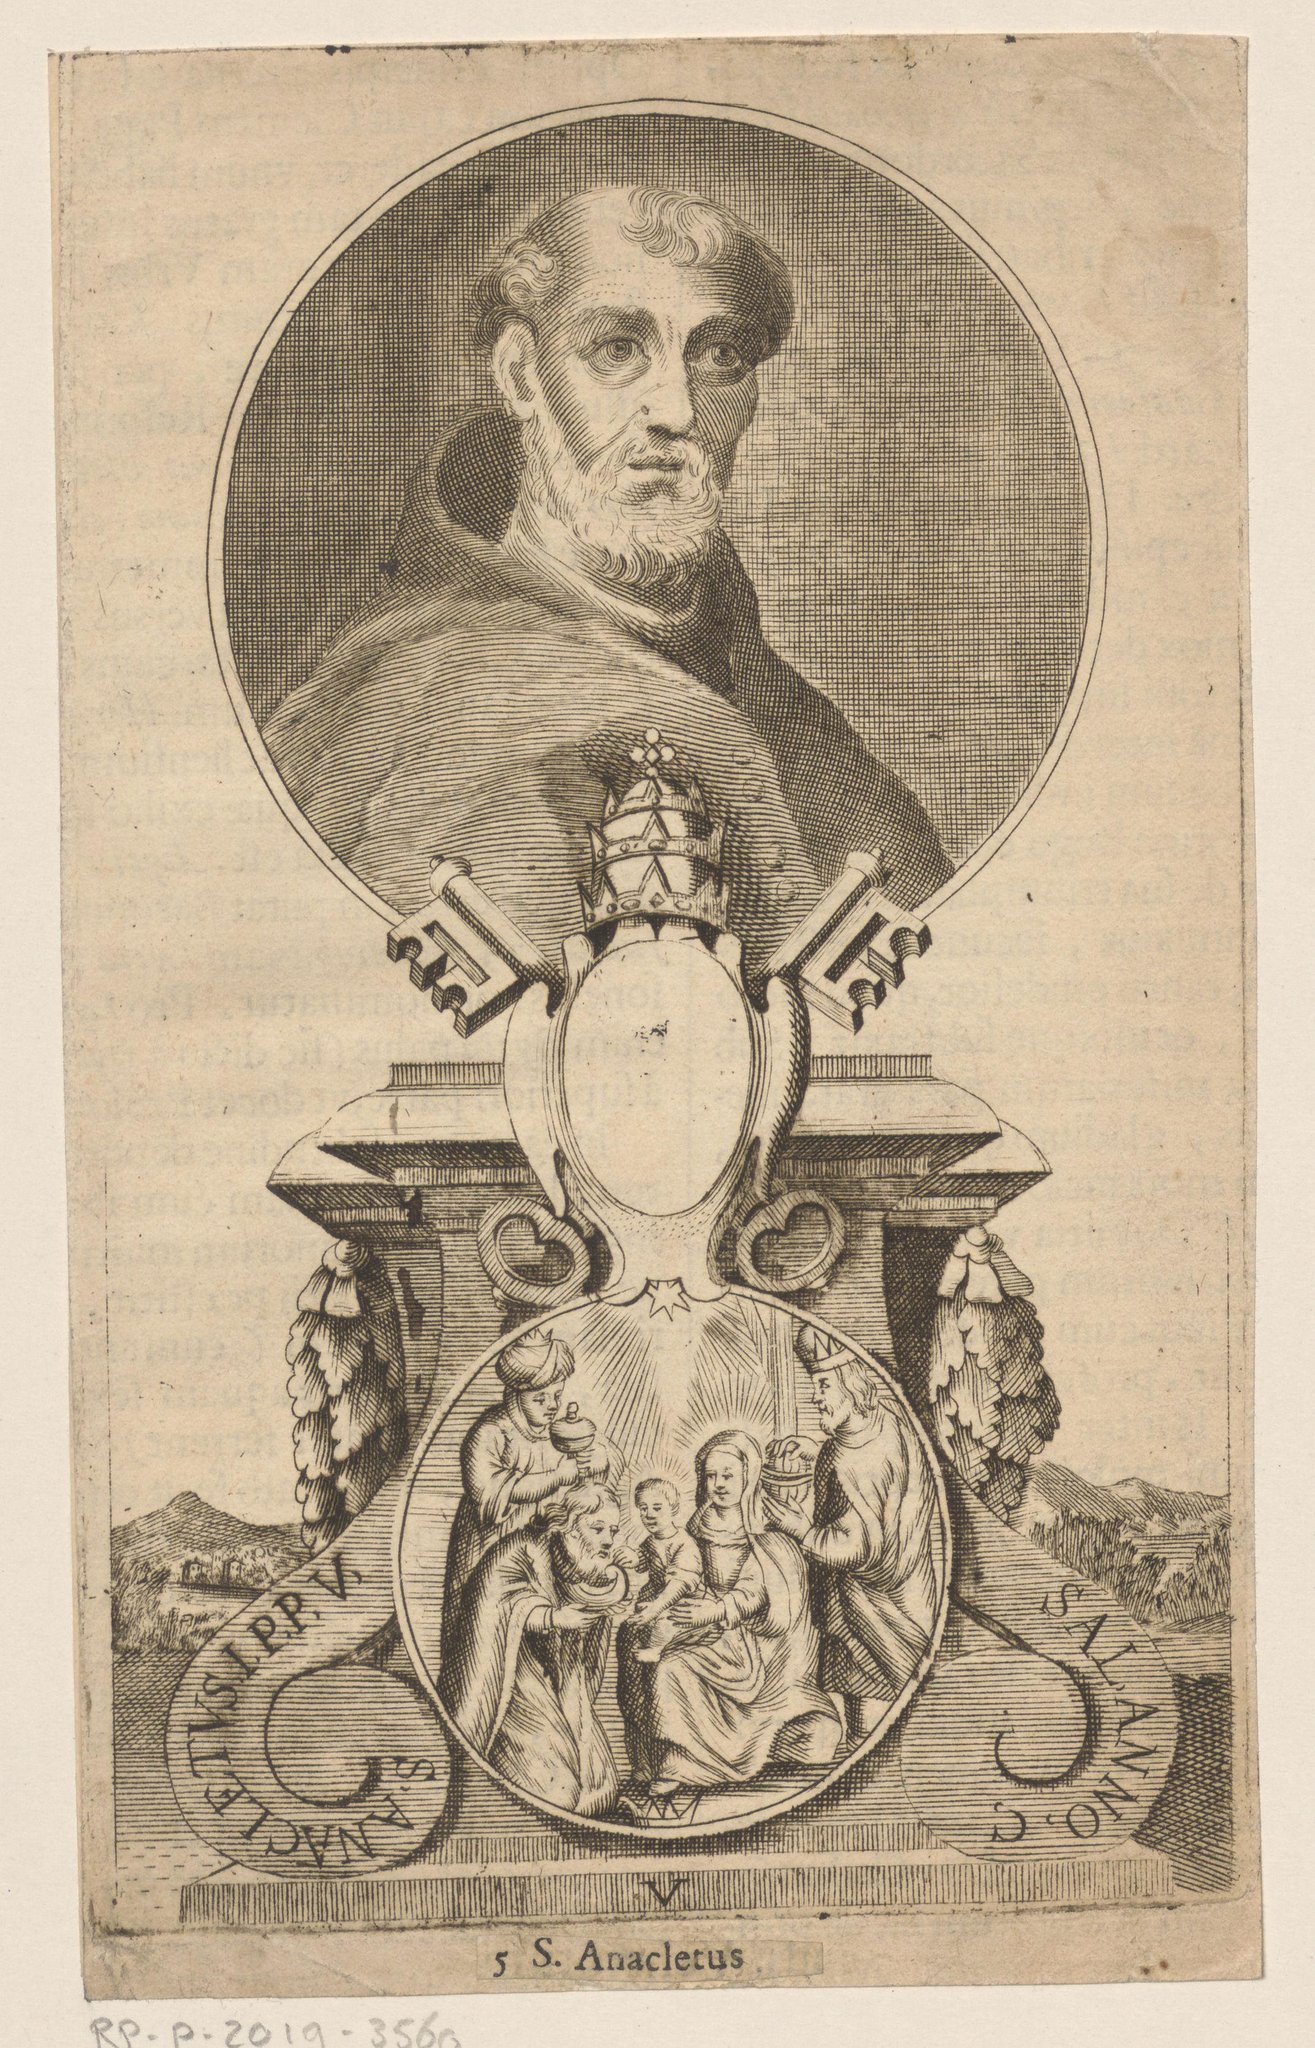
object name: book illustration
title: Portret van paus Anacletus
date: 1687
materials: paper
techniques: engraving, etching, letterpress printing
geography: venice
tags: historical persons, adoration of the kings: the wise men present their gifts to the christ-child (gold, frankincense and myrrh) (+ donor(s), supplicant(s), whether or not with patron saint(s))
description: Prent uit: Palazzi, Giovanni. Gesta pontificum Romanorum a Sancto Petro (...). Venetië: Giovanni Paré, 1687, p. 28.